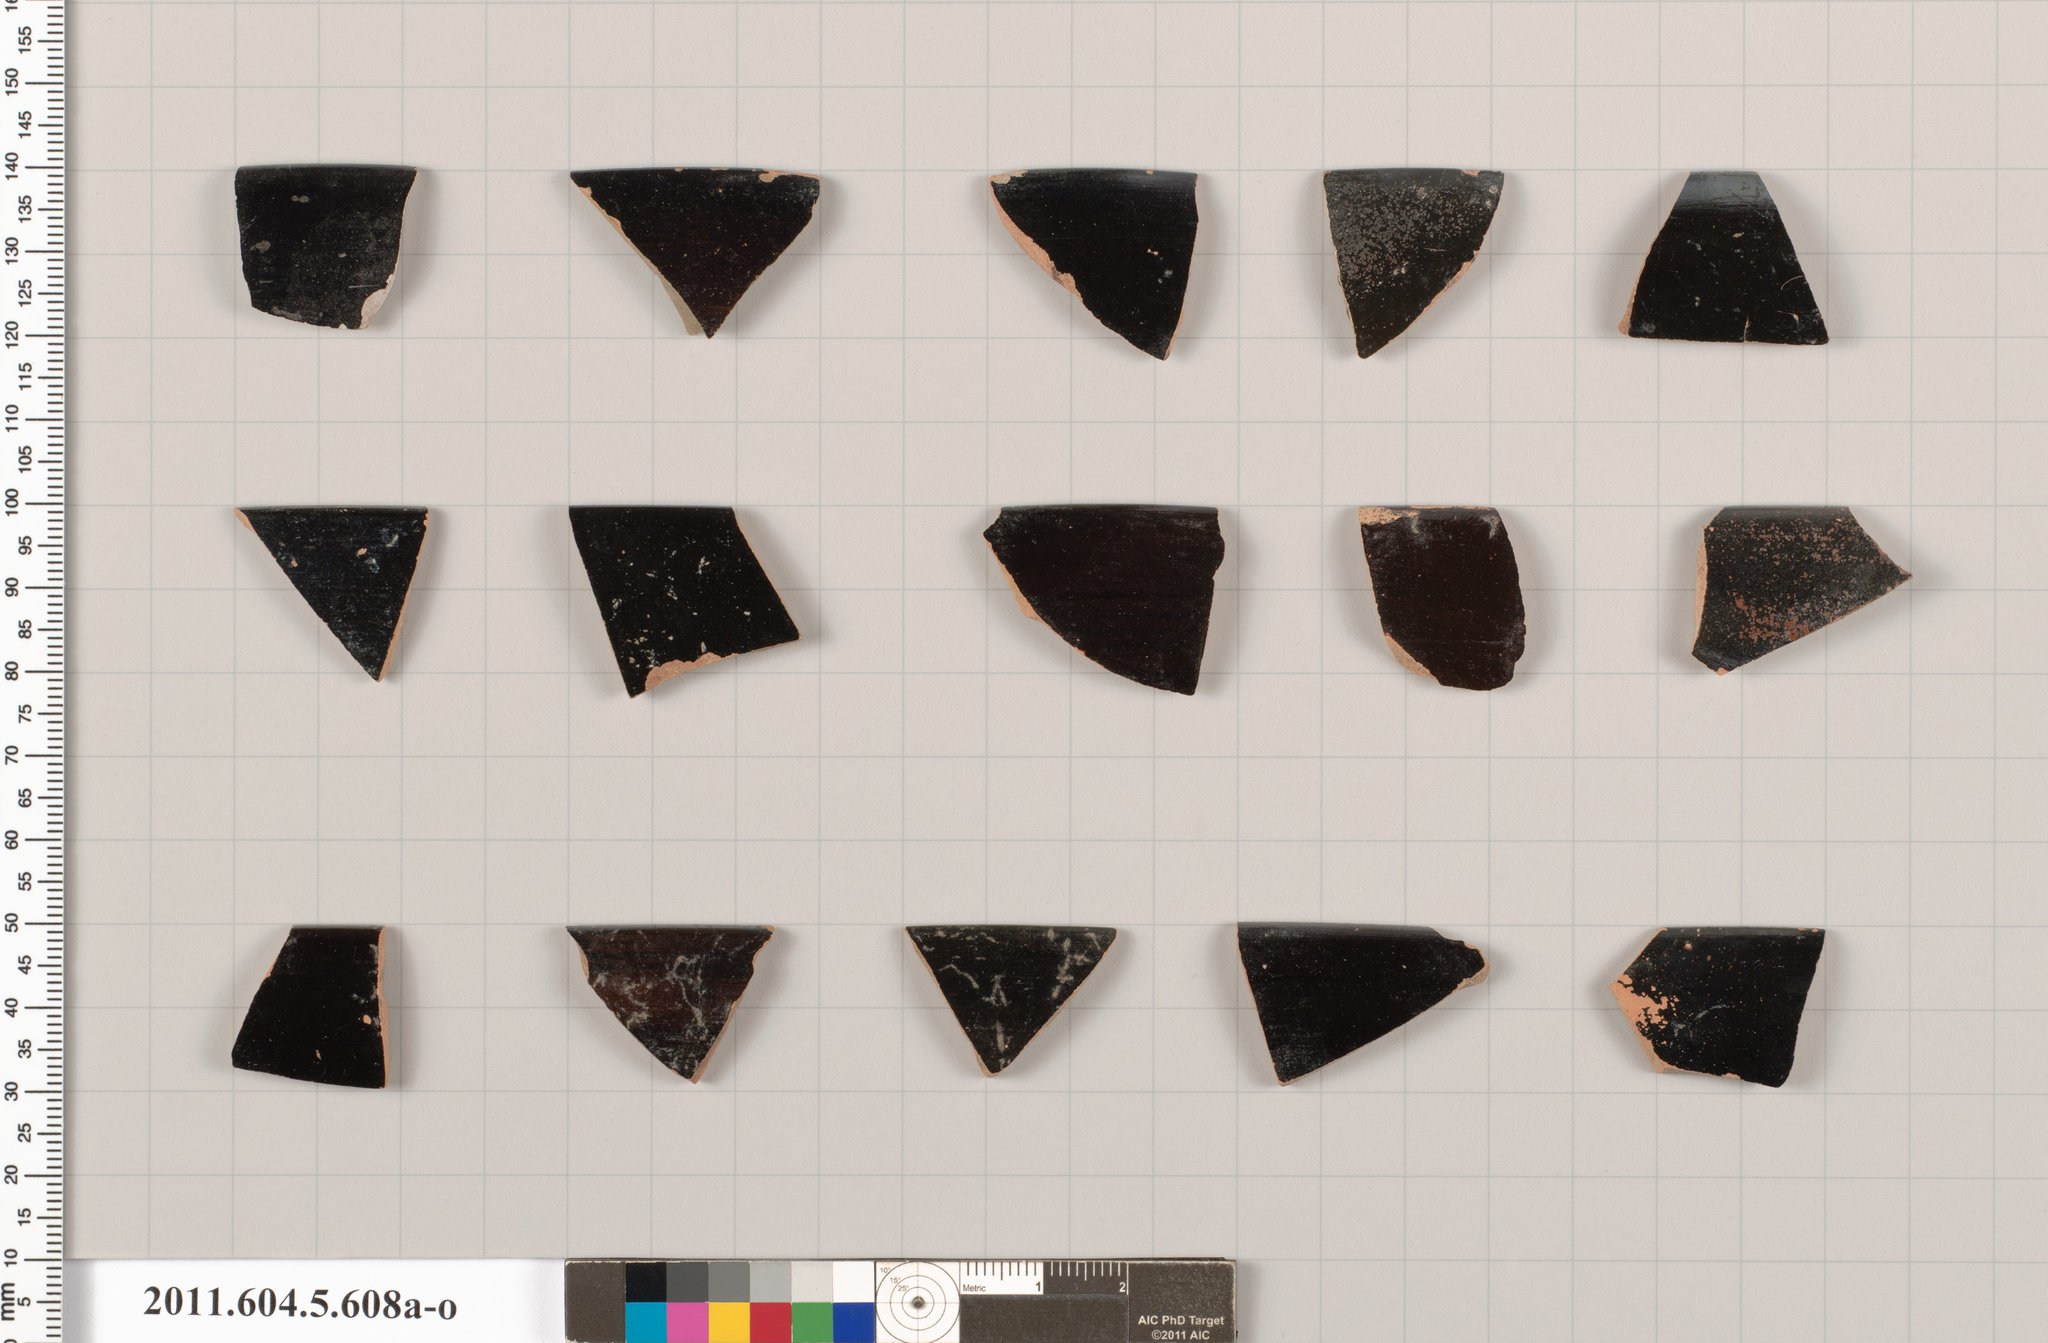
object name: kylix fragment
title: Terracotta rim fragments of kylikes (drinking cups)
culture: greek, attic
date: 600-401 BCE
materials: terracotta